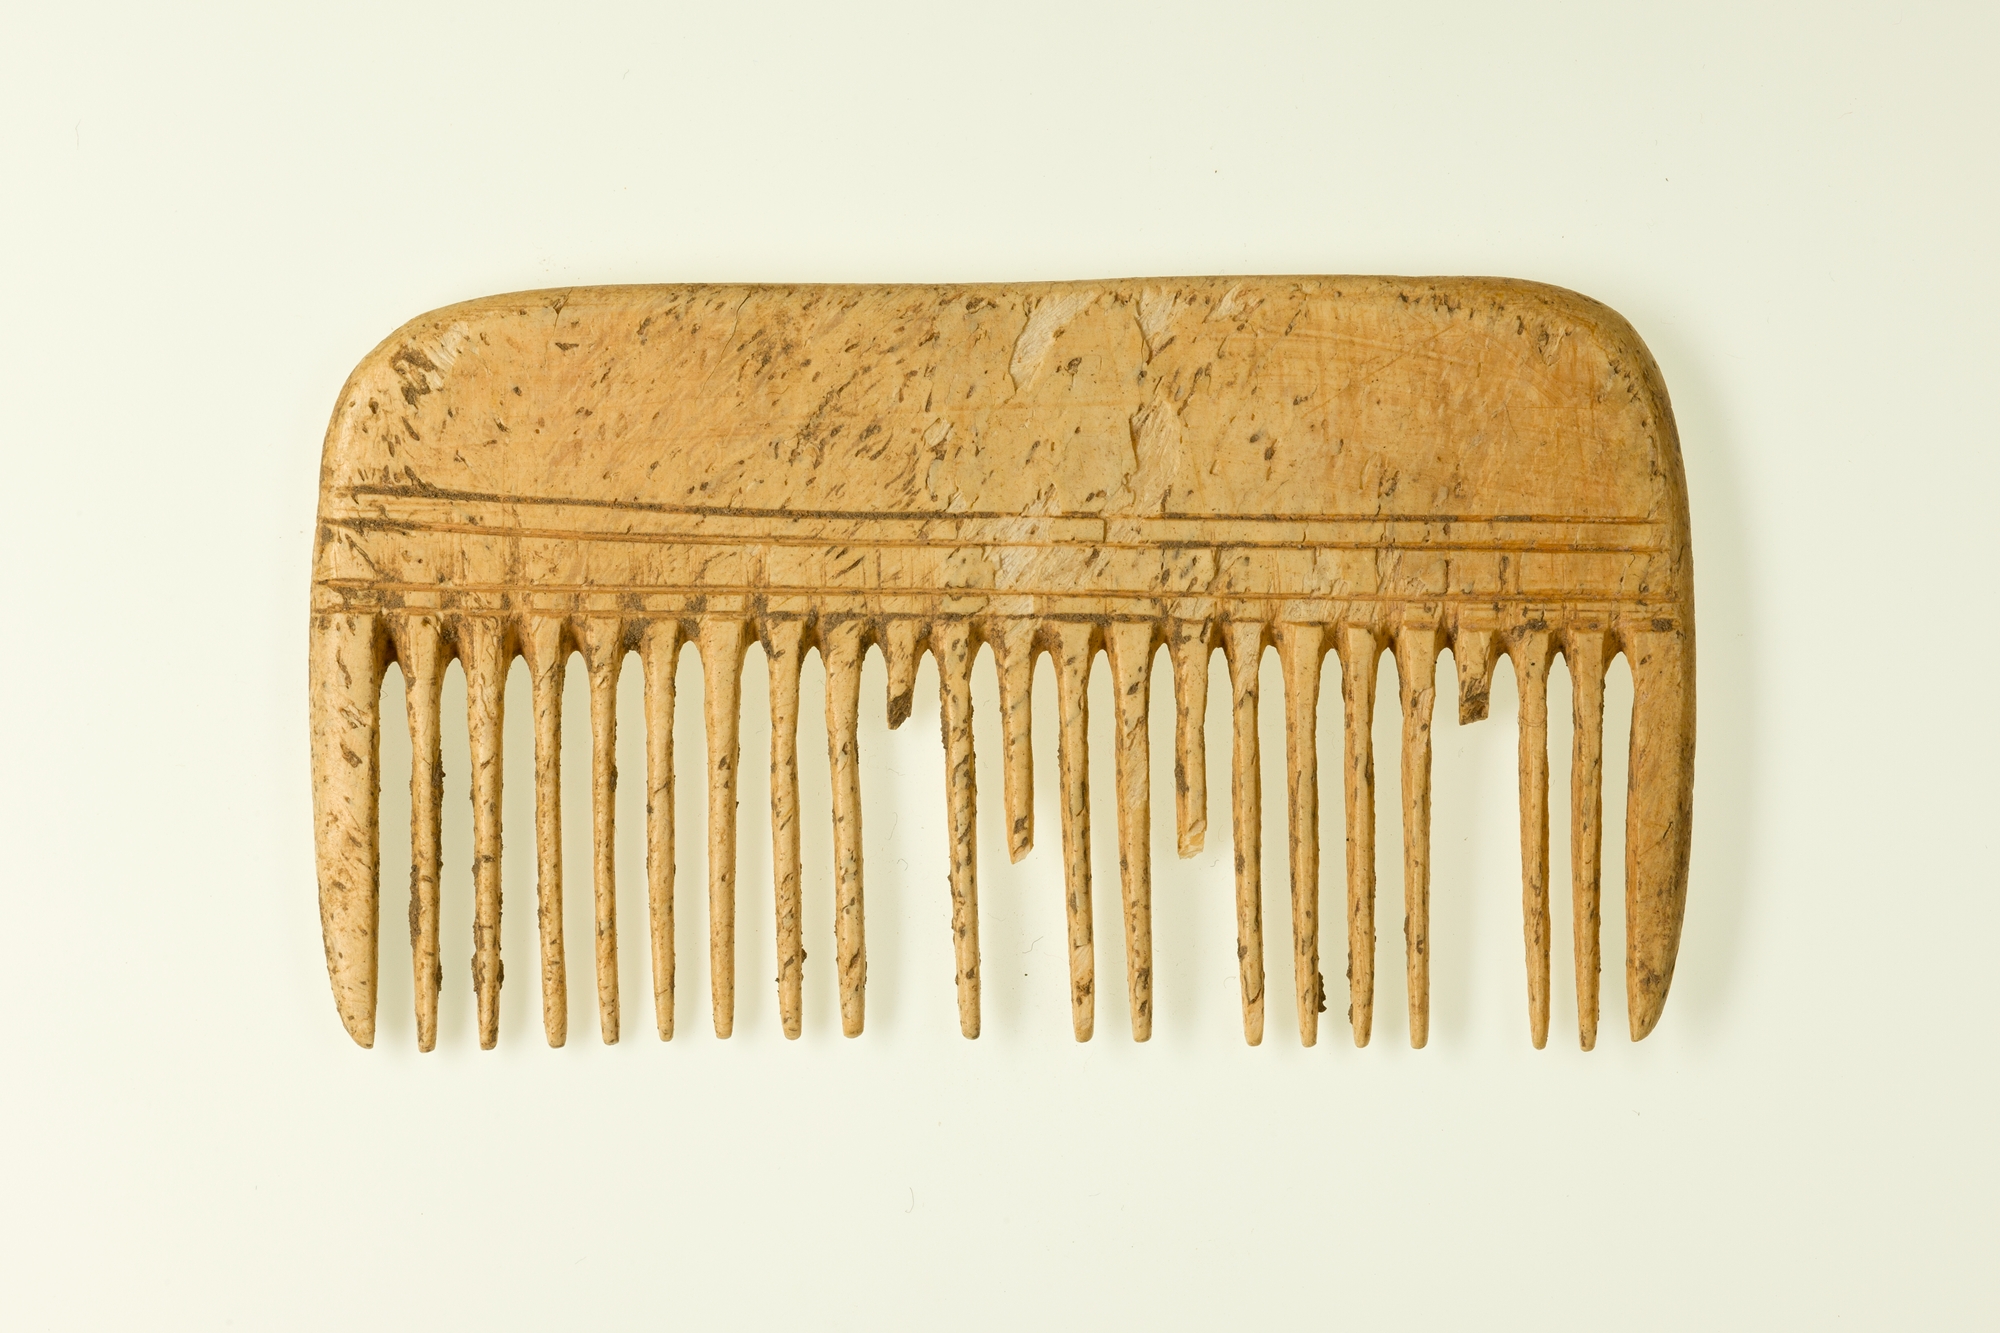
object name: comb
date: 1295-1070 BCE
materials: bone, ivory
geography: egypt